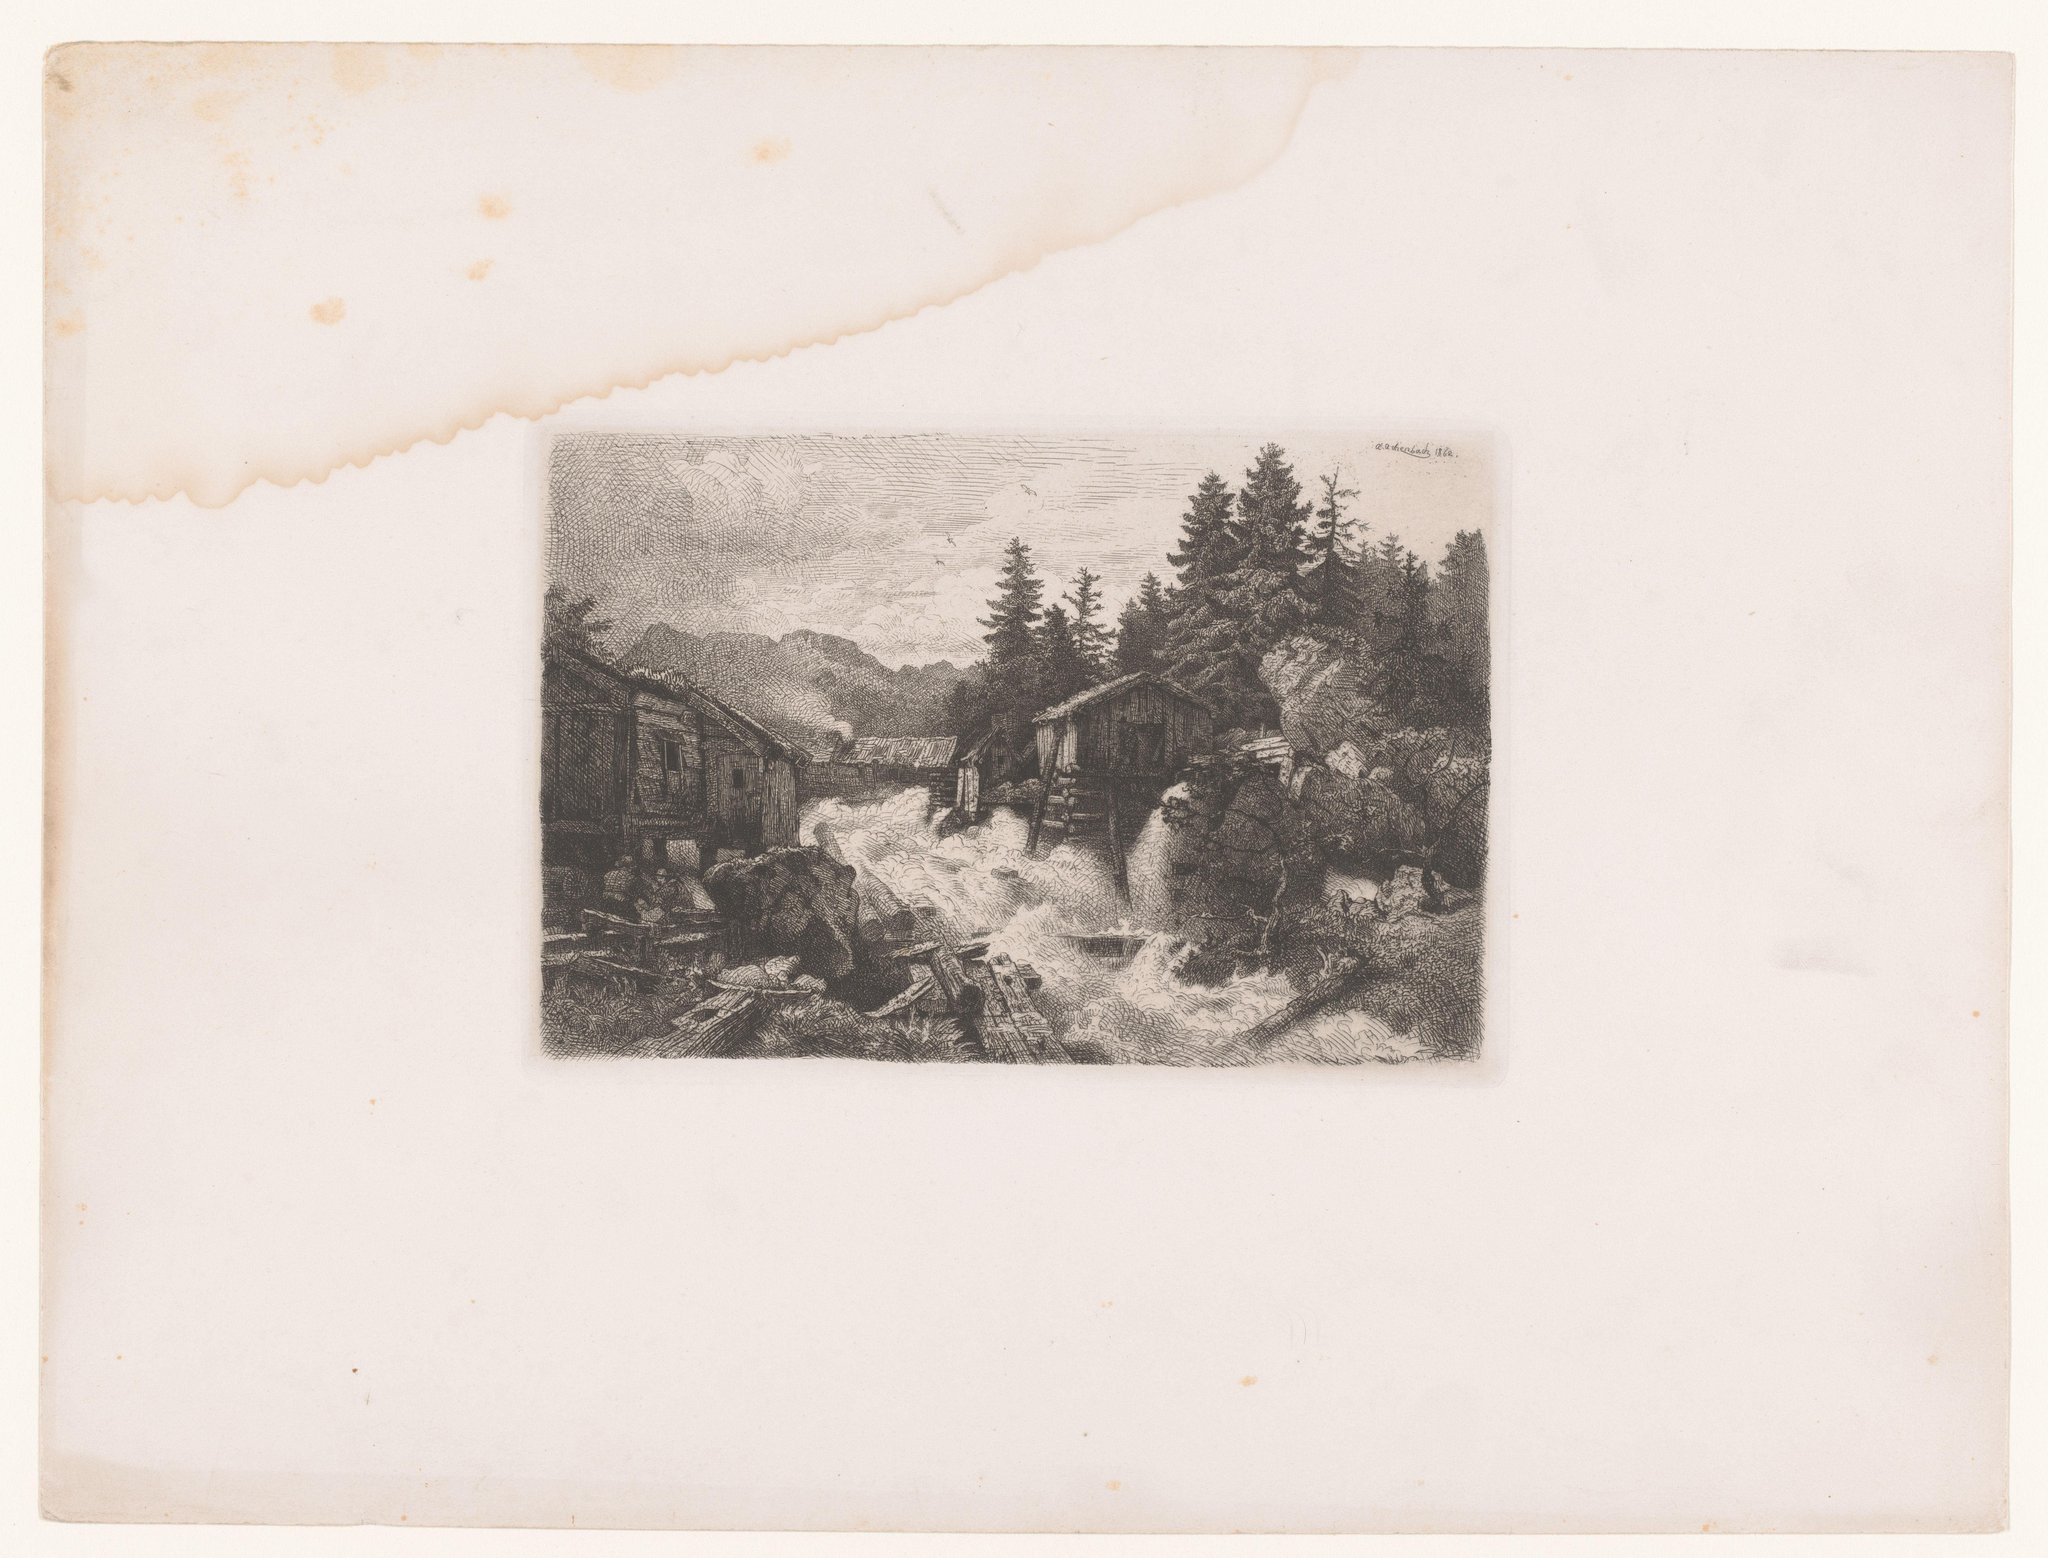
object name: print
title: Boslandschap met een waterval en houten huizen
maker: andreas achenbach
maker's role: print maker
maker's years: 1815-1910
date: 1862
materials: paper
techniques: etching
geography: dusseldorf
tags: log-cabin, waterfall, forest, wood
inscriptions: collector's mark: Lugt 2228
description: Deze prent maakt deel uit van een serie van twaalf prenten met landschappen en zeegezichten.